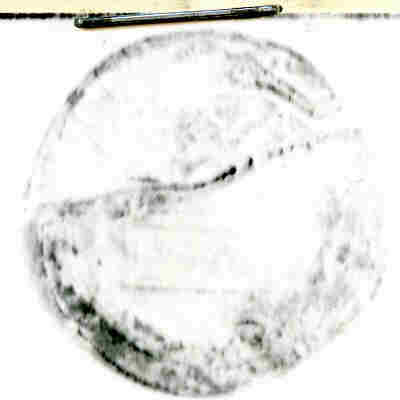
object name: coin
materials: silver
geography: zaranj